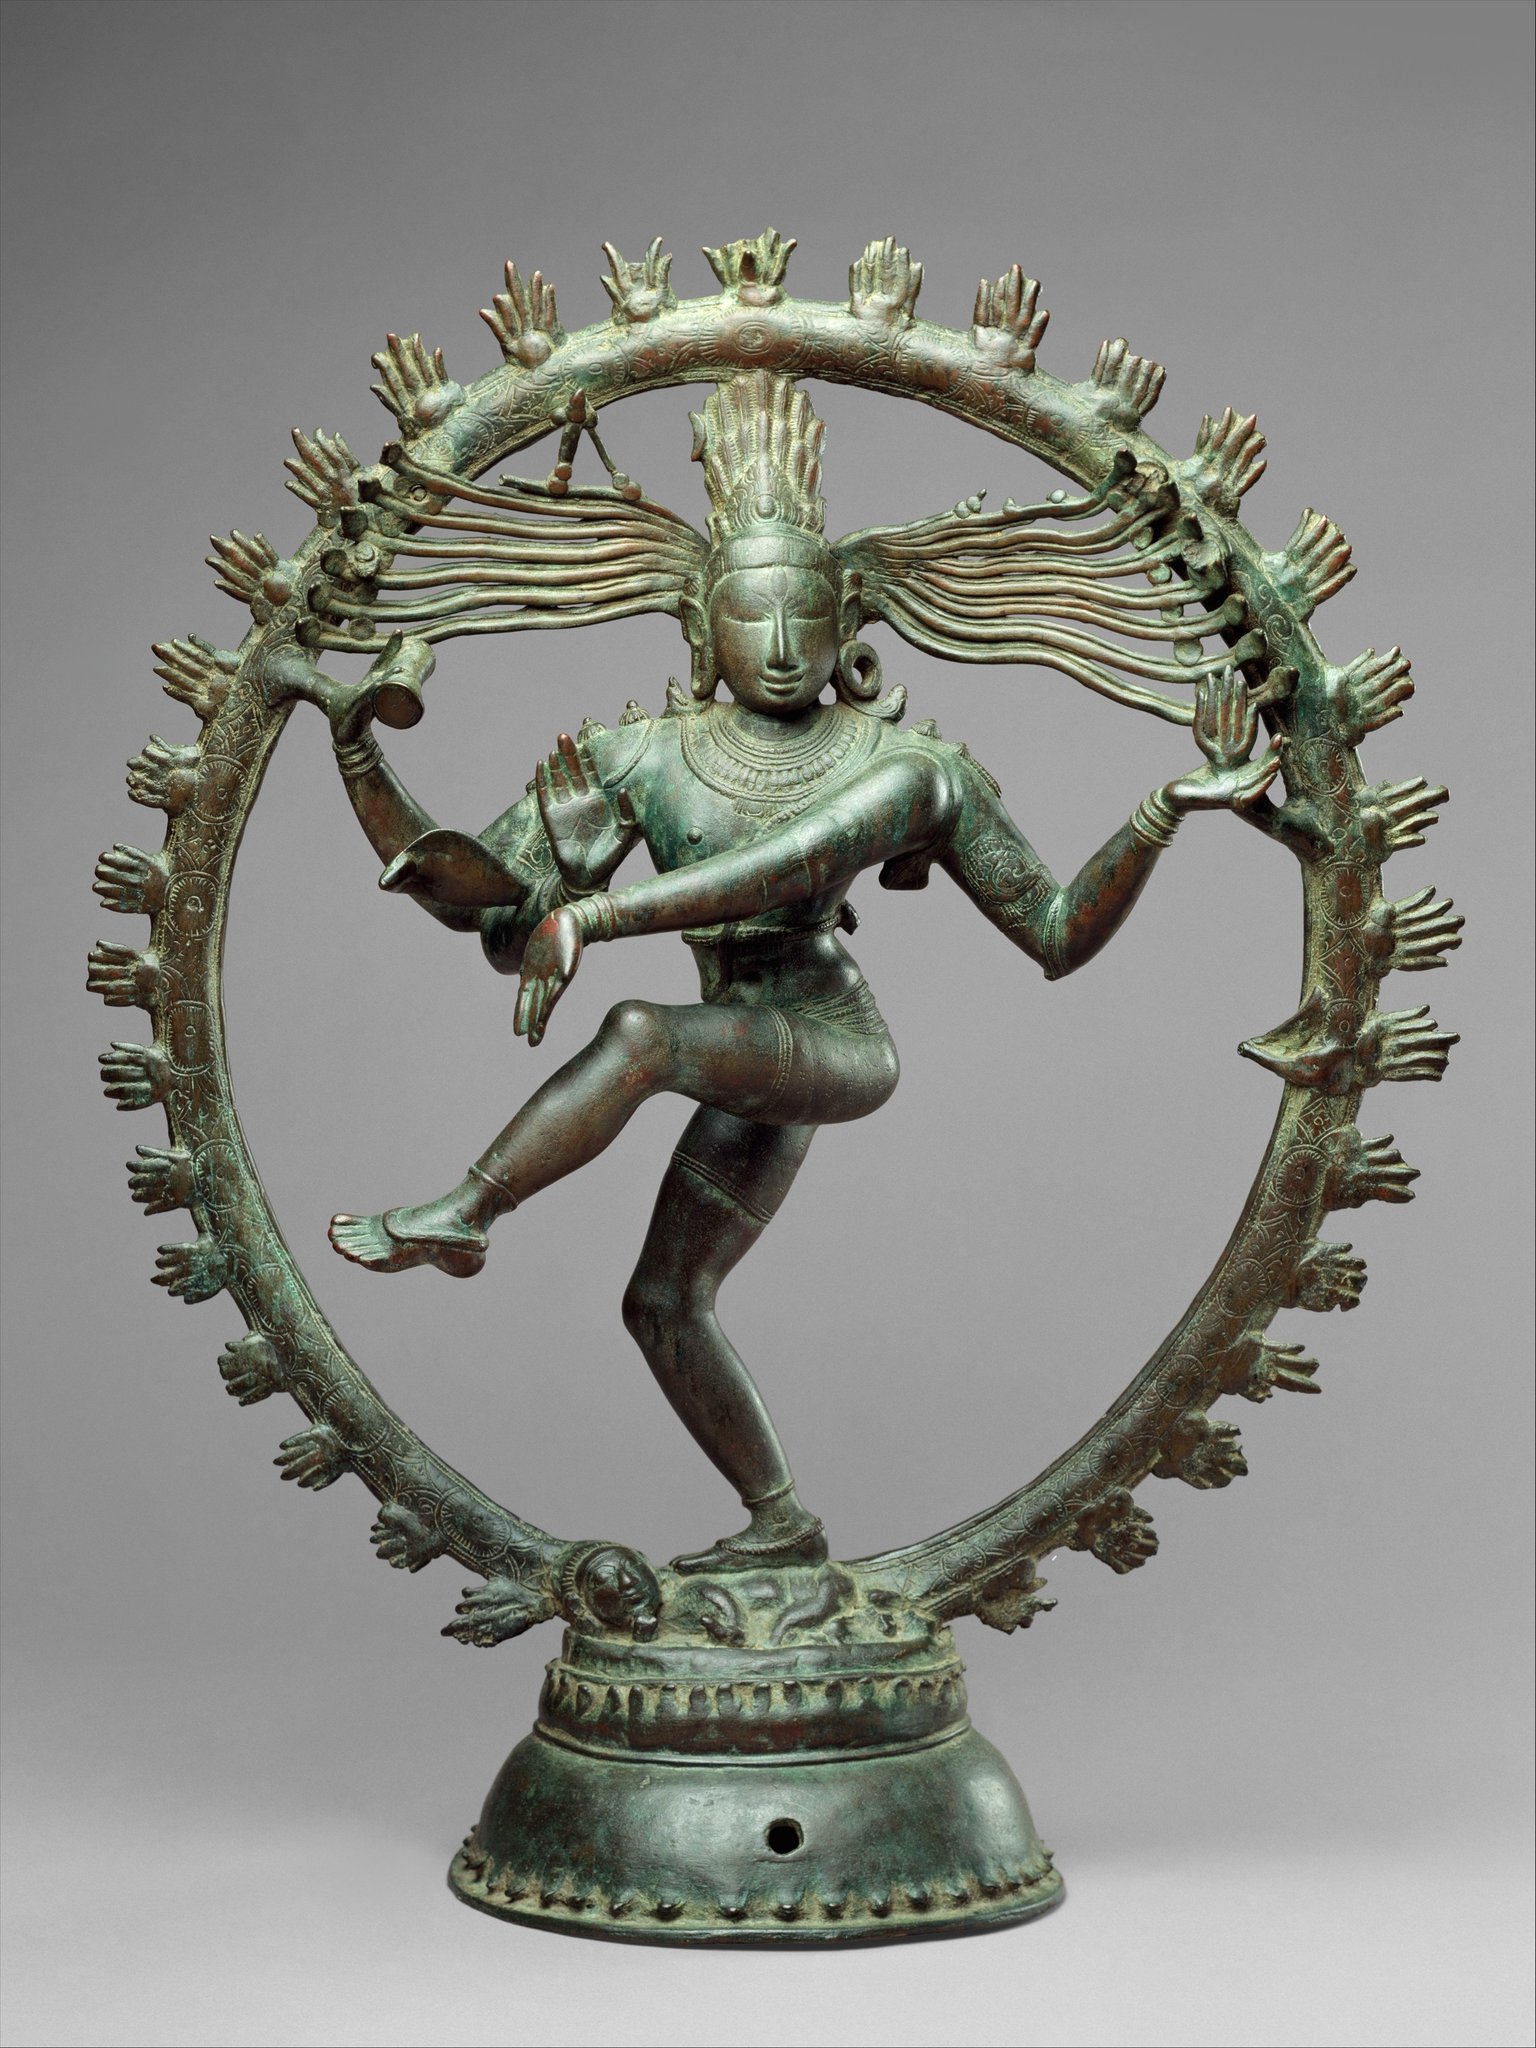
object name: figure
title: Shiva as Lord of Dance (Nataraja)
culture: indian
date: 1001-1100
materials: copper alloy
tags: dancing,shiva